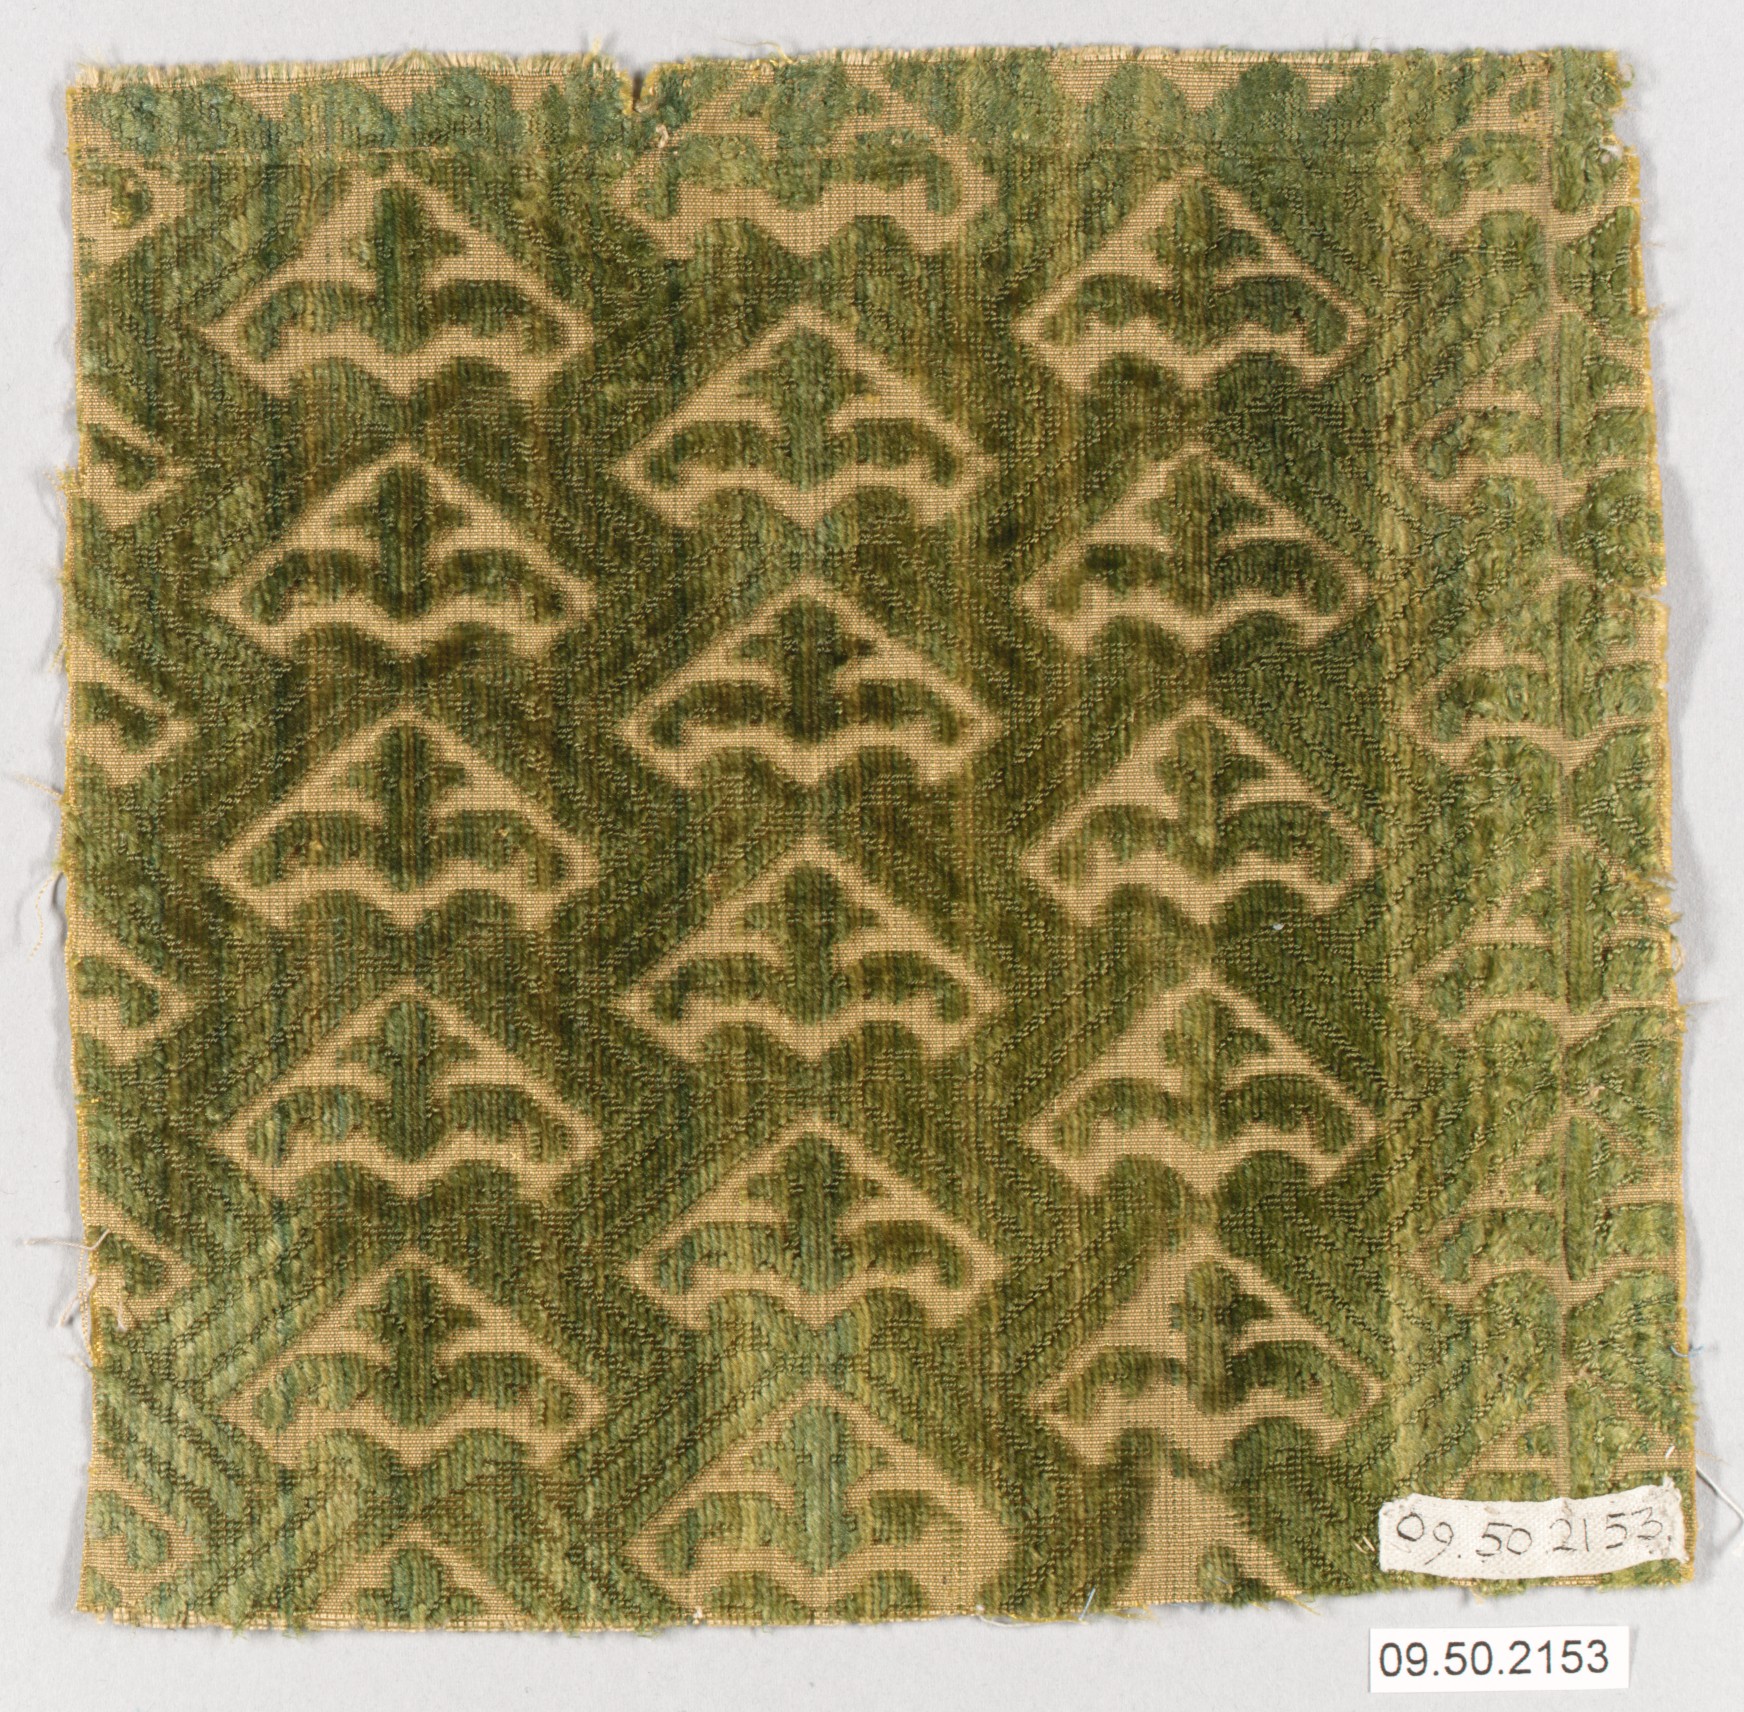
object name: piece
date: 1501-1700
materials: silk